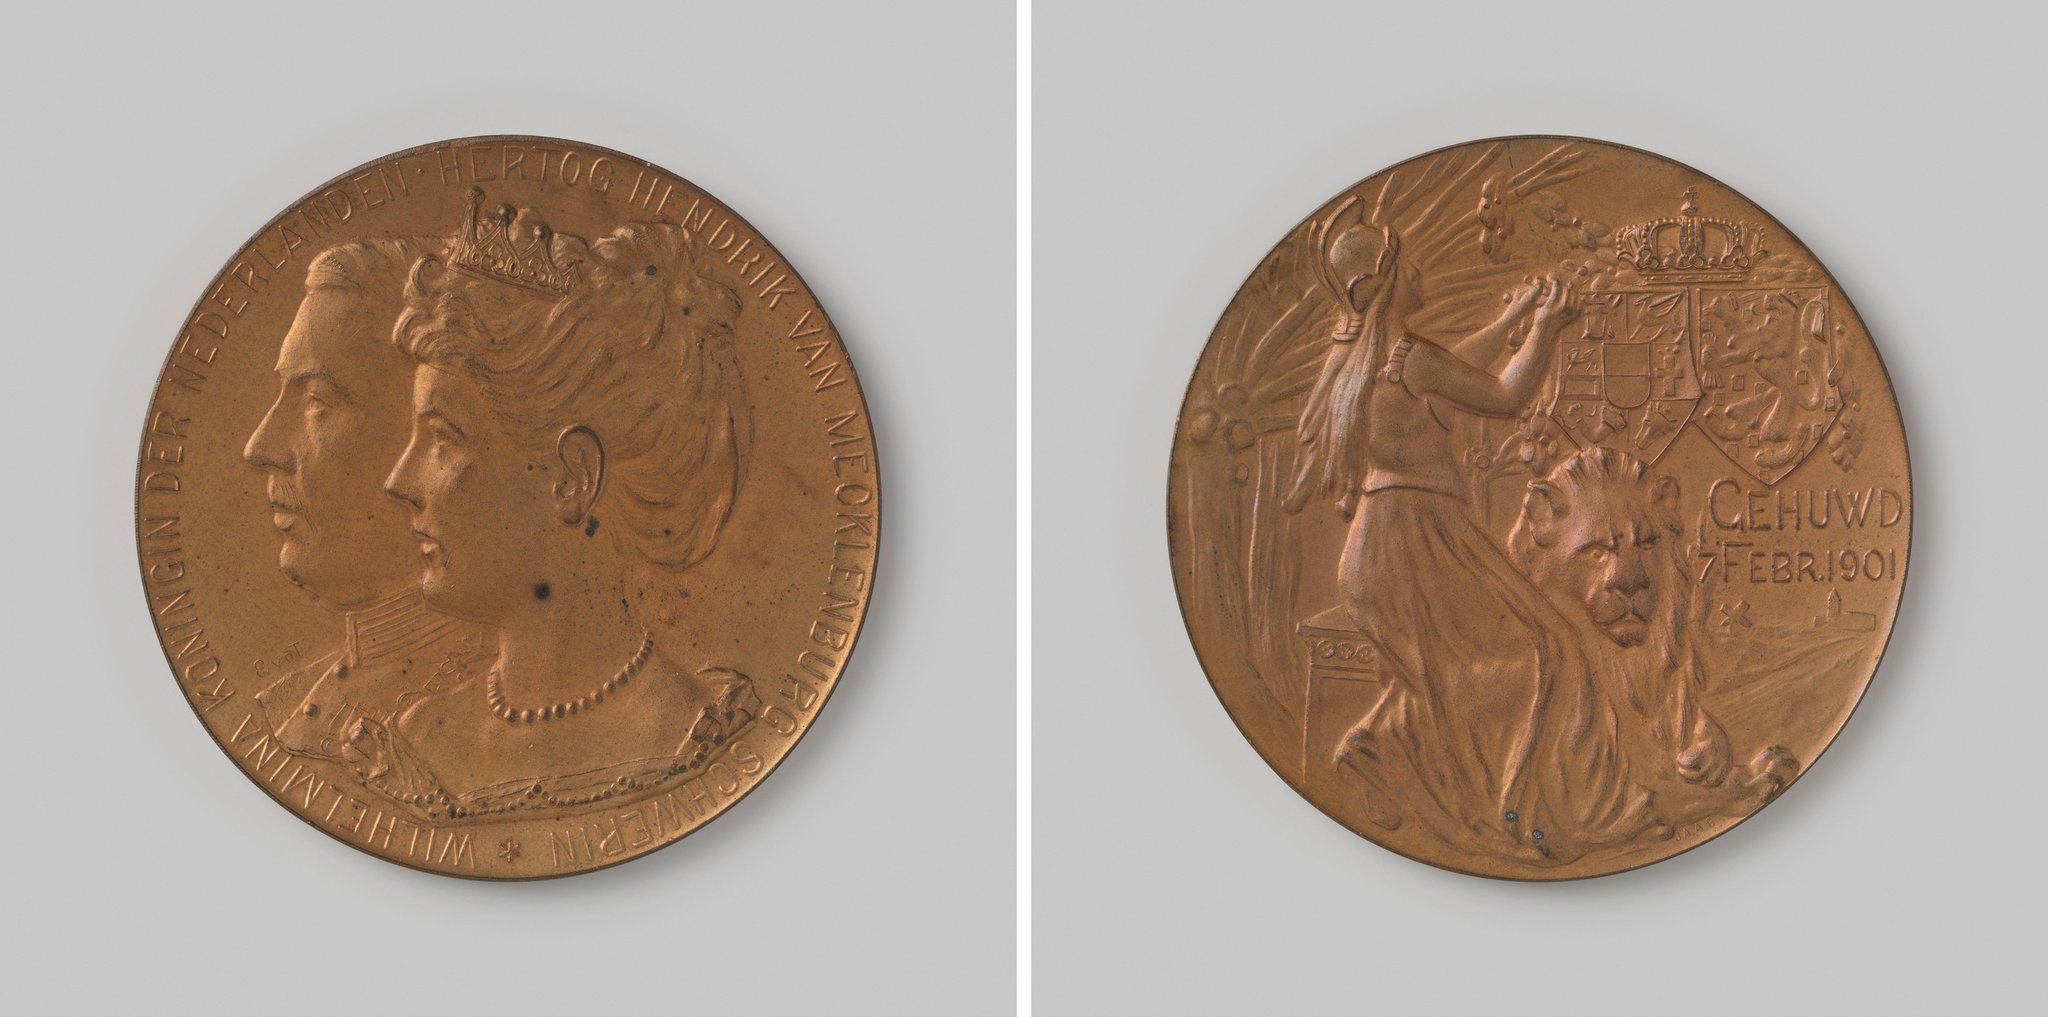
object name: history medal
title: Huwelijk van Koningin Wilhelmina met Hendrik van Mecklenburg-Schwerin 1901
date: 1901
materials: bronze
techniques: striking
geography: zeist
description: Bronzen penning, op de voorzijde de geconjugeerde borstbeelden van Hendrik en Wilhelmina naar links met omschrift, op de keerzijde de gehelmde Nederlandse Maagd, een leeuw aan haar voeten, hangt een slinger van lauwertakken om de wapenschilden van Mecklenburg en Nederland onder één kroon, met rechts twee regels tekst.